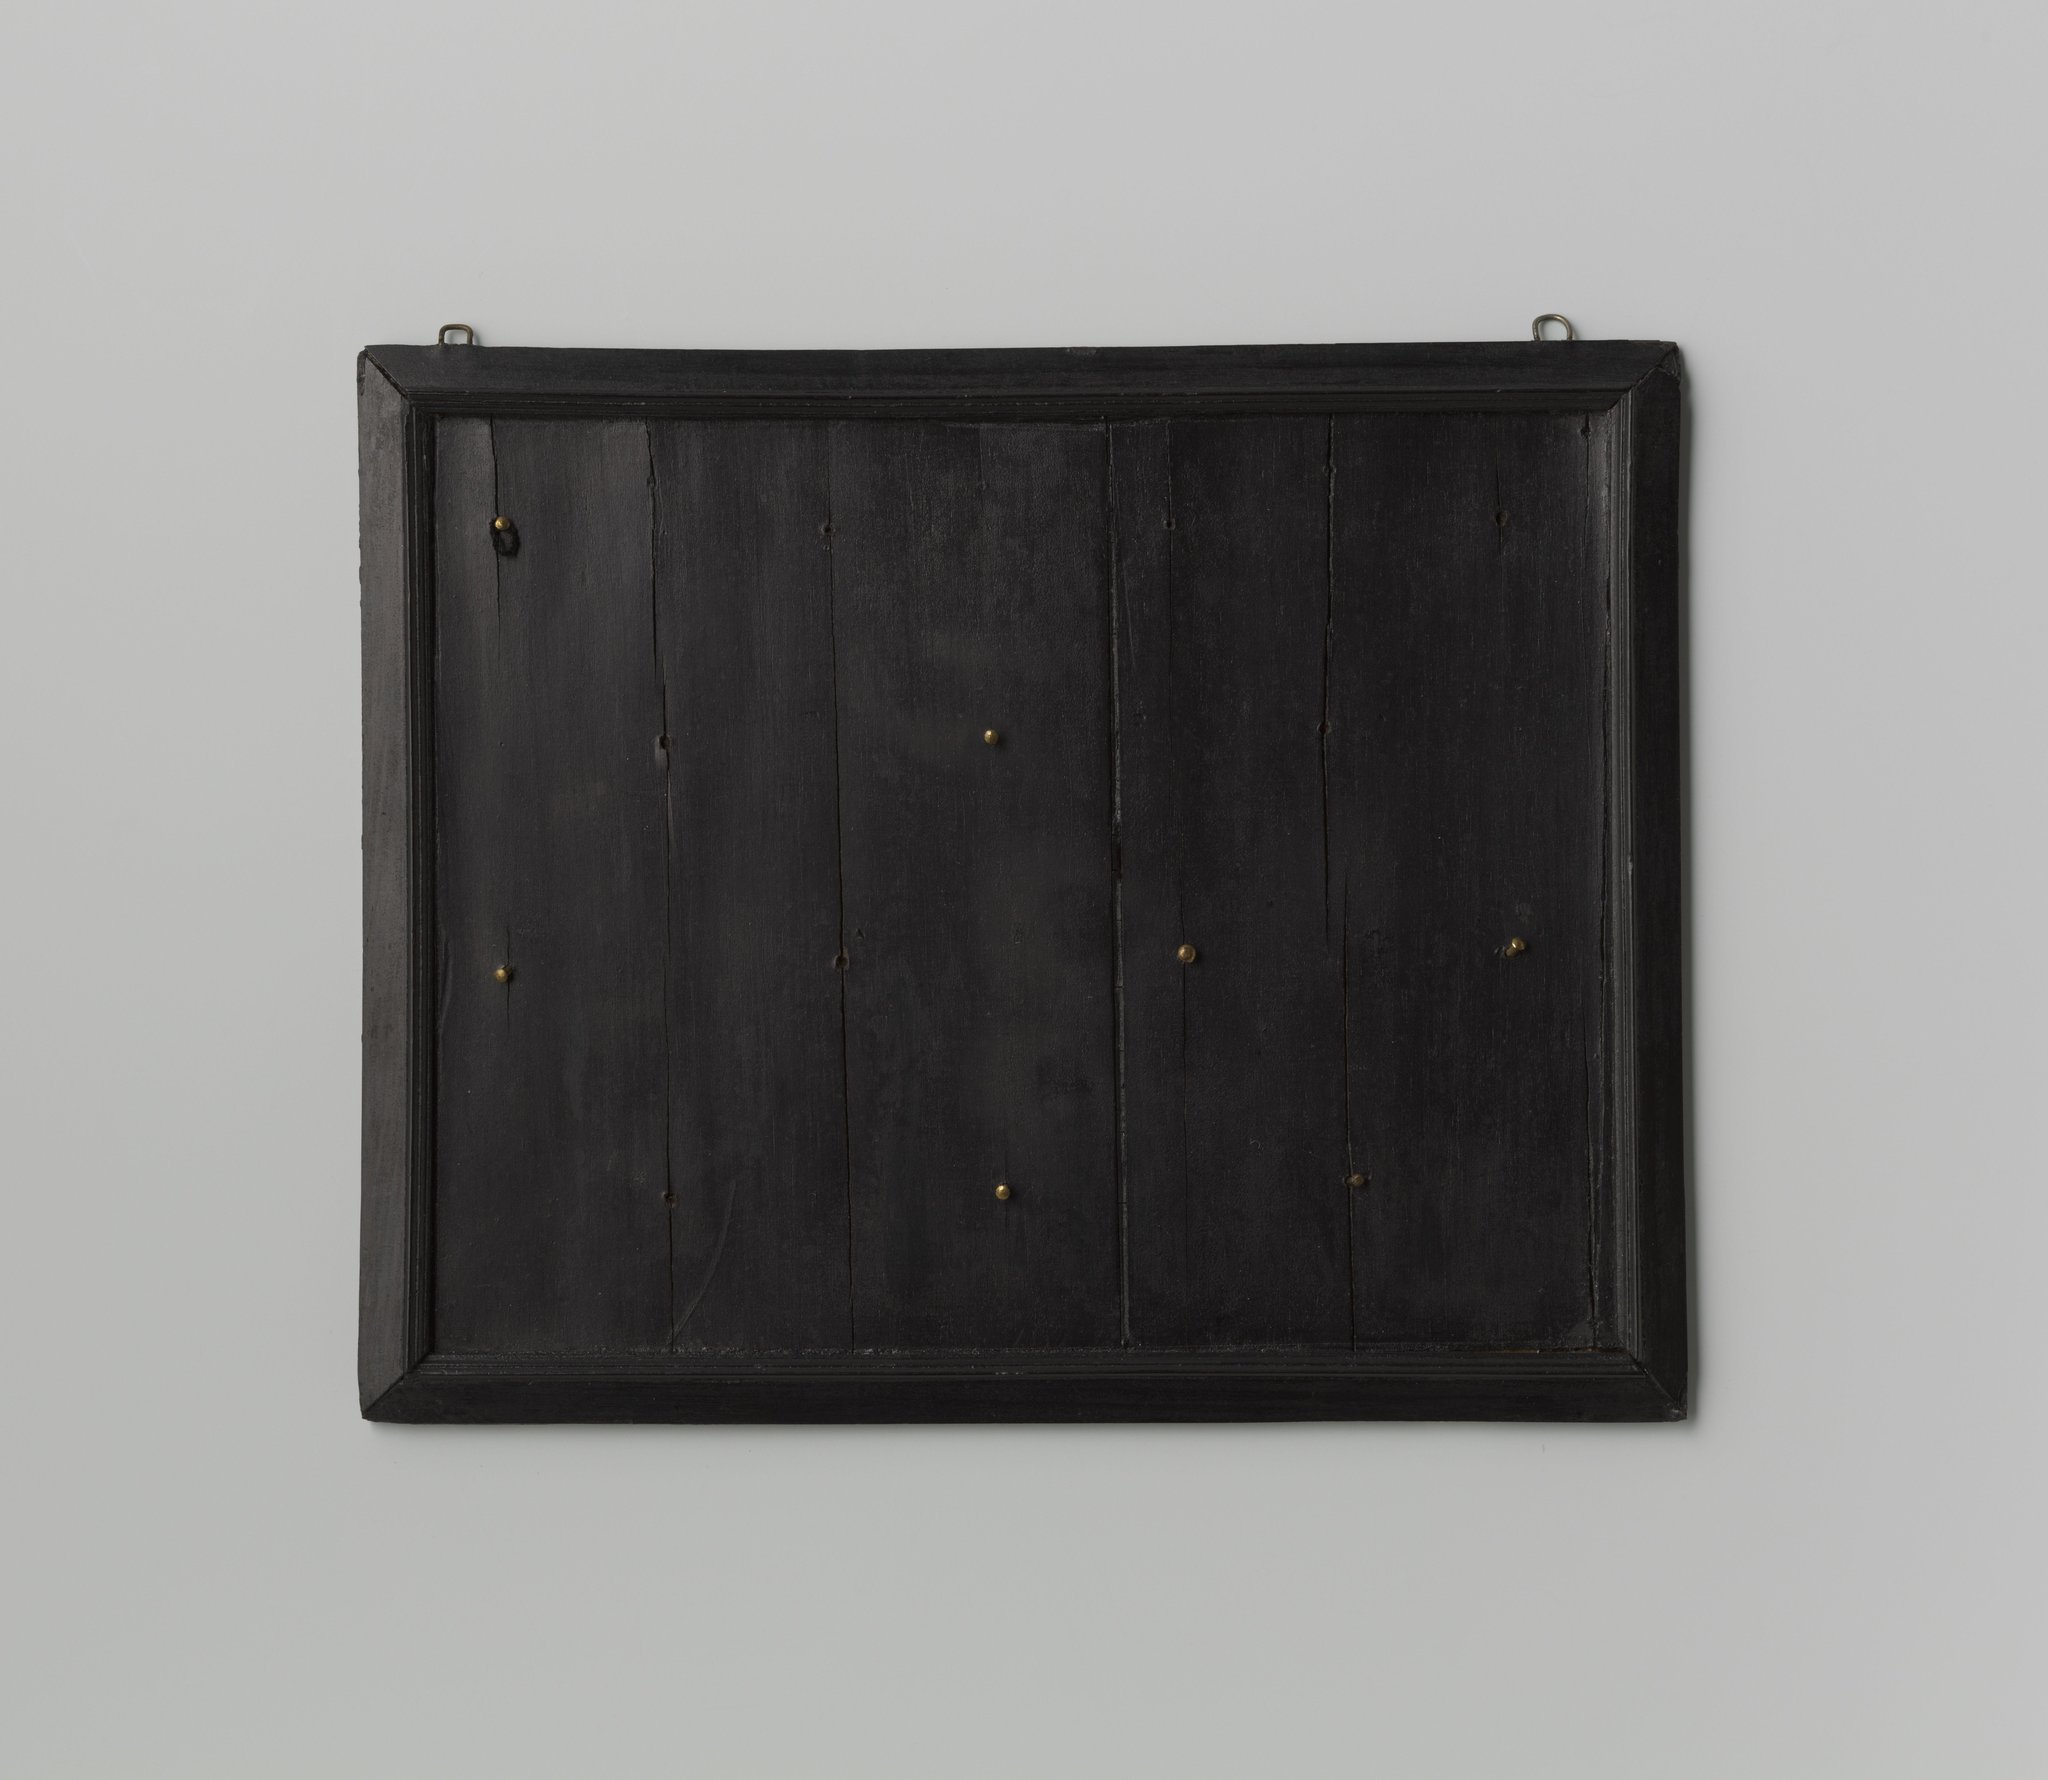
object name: plate dish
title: Groot rechthoekig wandbord, van ebbenhout, met geprofileerde omlijsting, en voorzien van oorspronkelijk veertien spijkertjes van koper, regelmatig verdeeld over het wandvlak.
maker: Anonymous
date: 1690-1710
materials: brass, wood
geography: amsterdam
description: Groot rechthoekig wandbord, vervaardigd van een plaat ebbenhout, met geprofileerde omlijsting, en voorzien van oorspronkelijk veertien spijkertjes van koper, regelmatig verdeeld over het wand vlak (nog zeven aanwezig). Het ebbenhout is geplakt op een dunne messing plaat, hij hangt aan twee koperen draadoogjes.